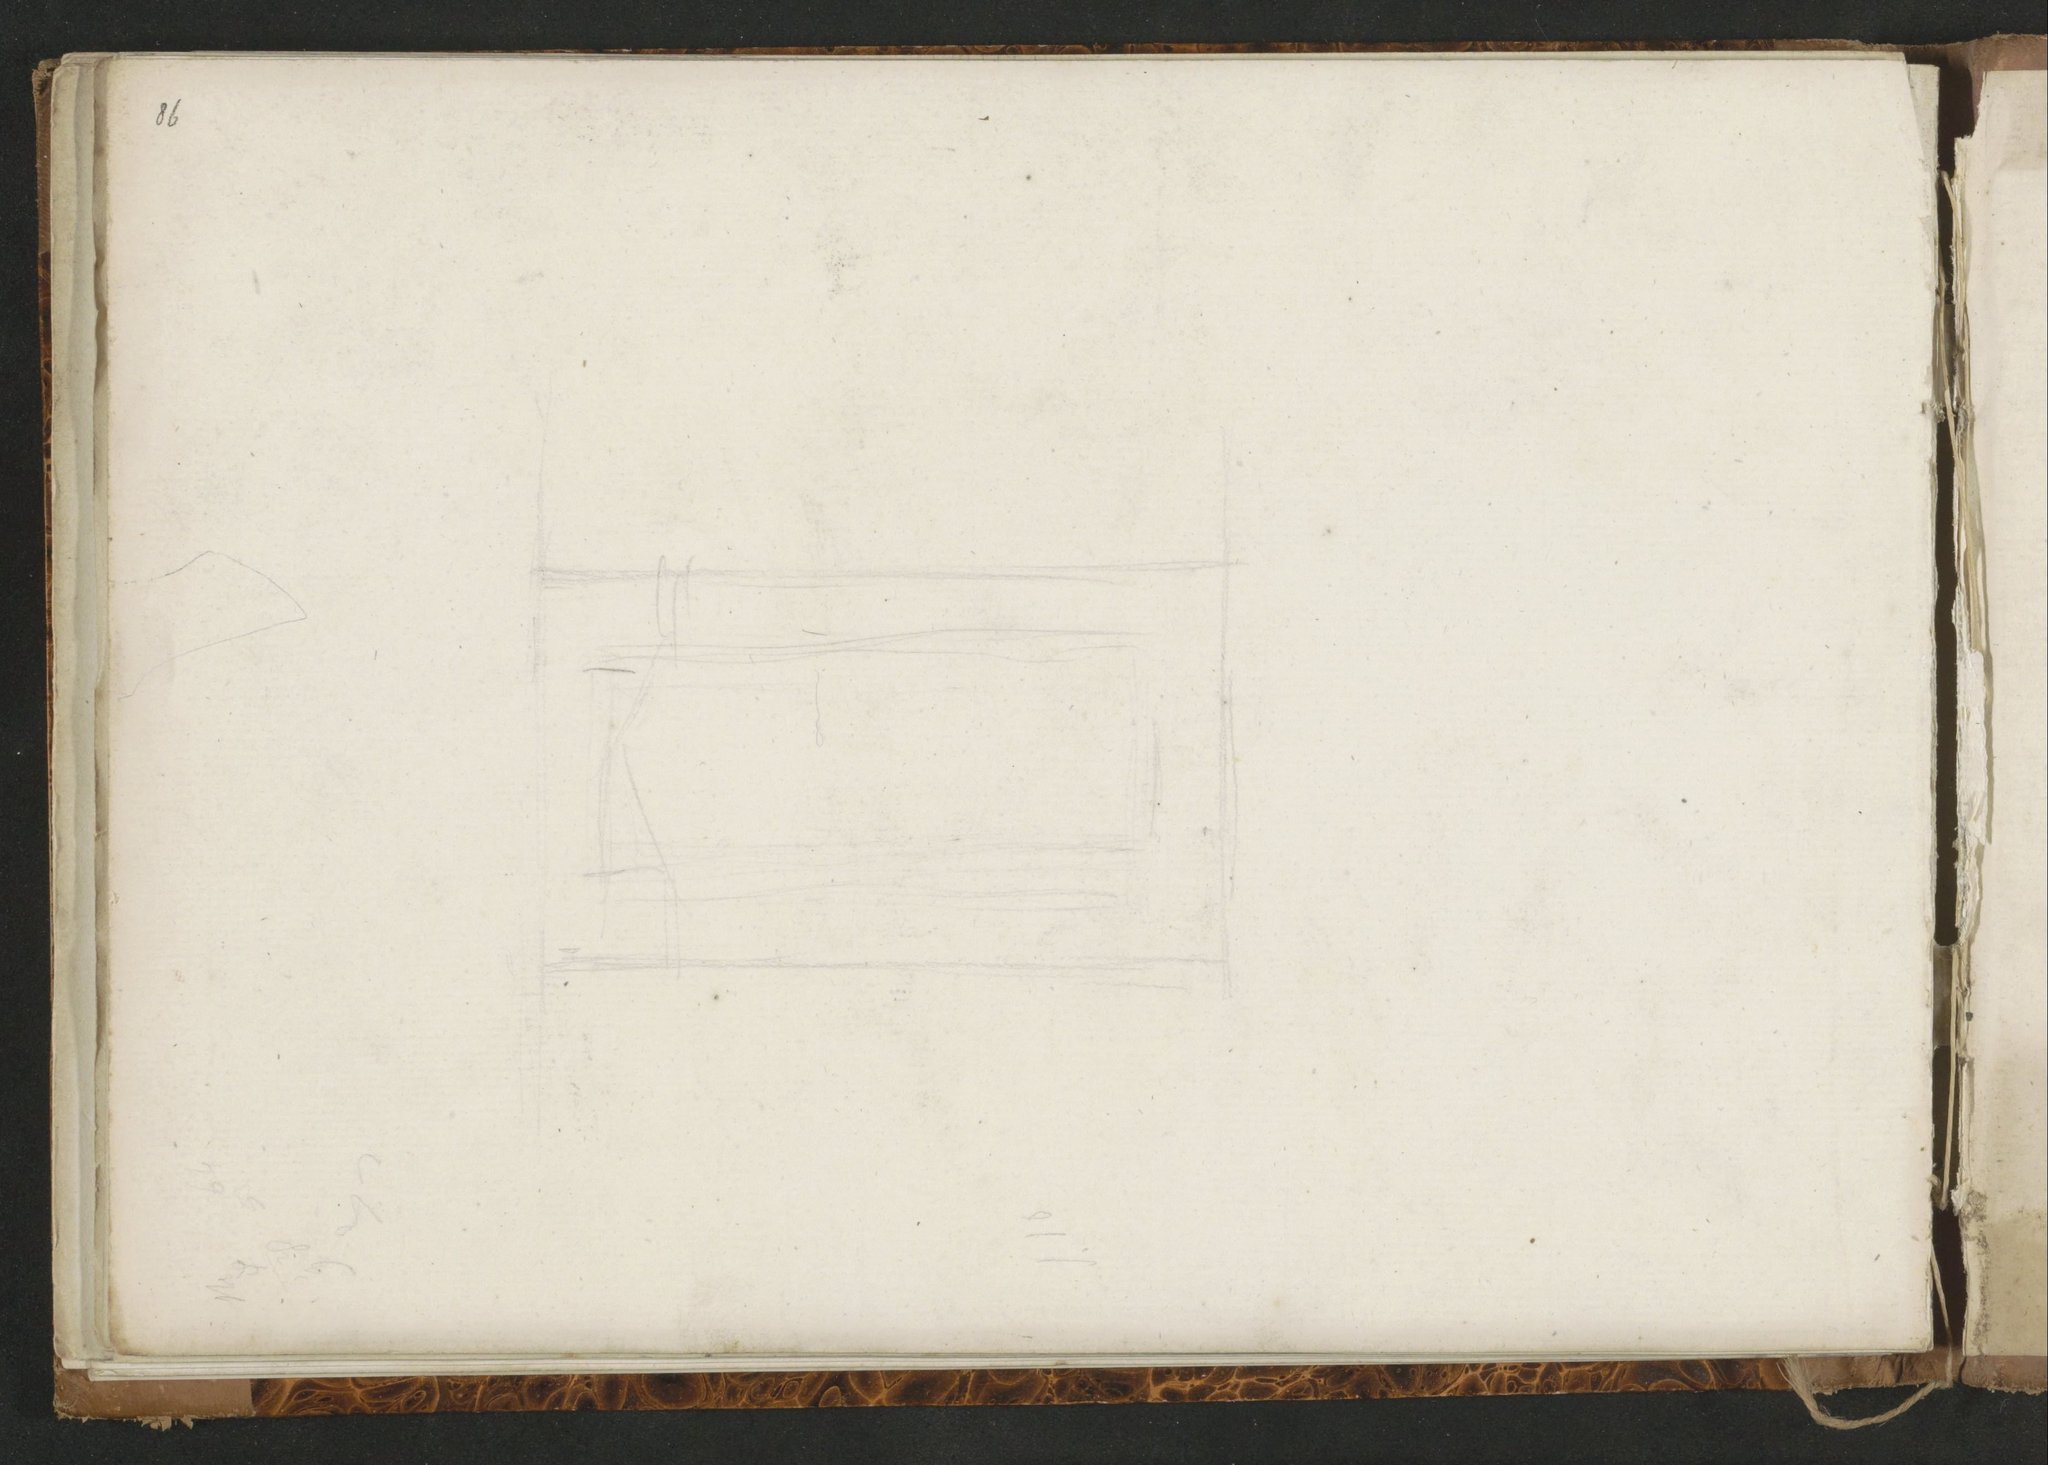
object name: sketchbook leaf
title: Rechthoek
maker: willem springer jr.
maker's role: draughtsman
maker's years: 1815-1907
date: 1825-1907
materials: paper, pencil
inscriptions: annotation: ‘...’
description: Pagina 86 uit een schetsboek met 86 pagina's.